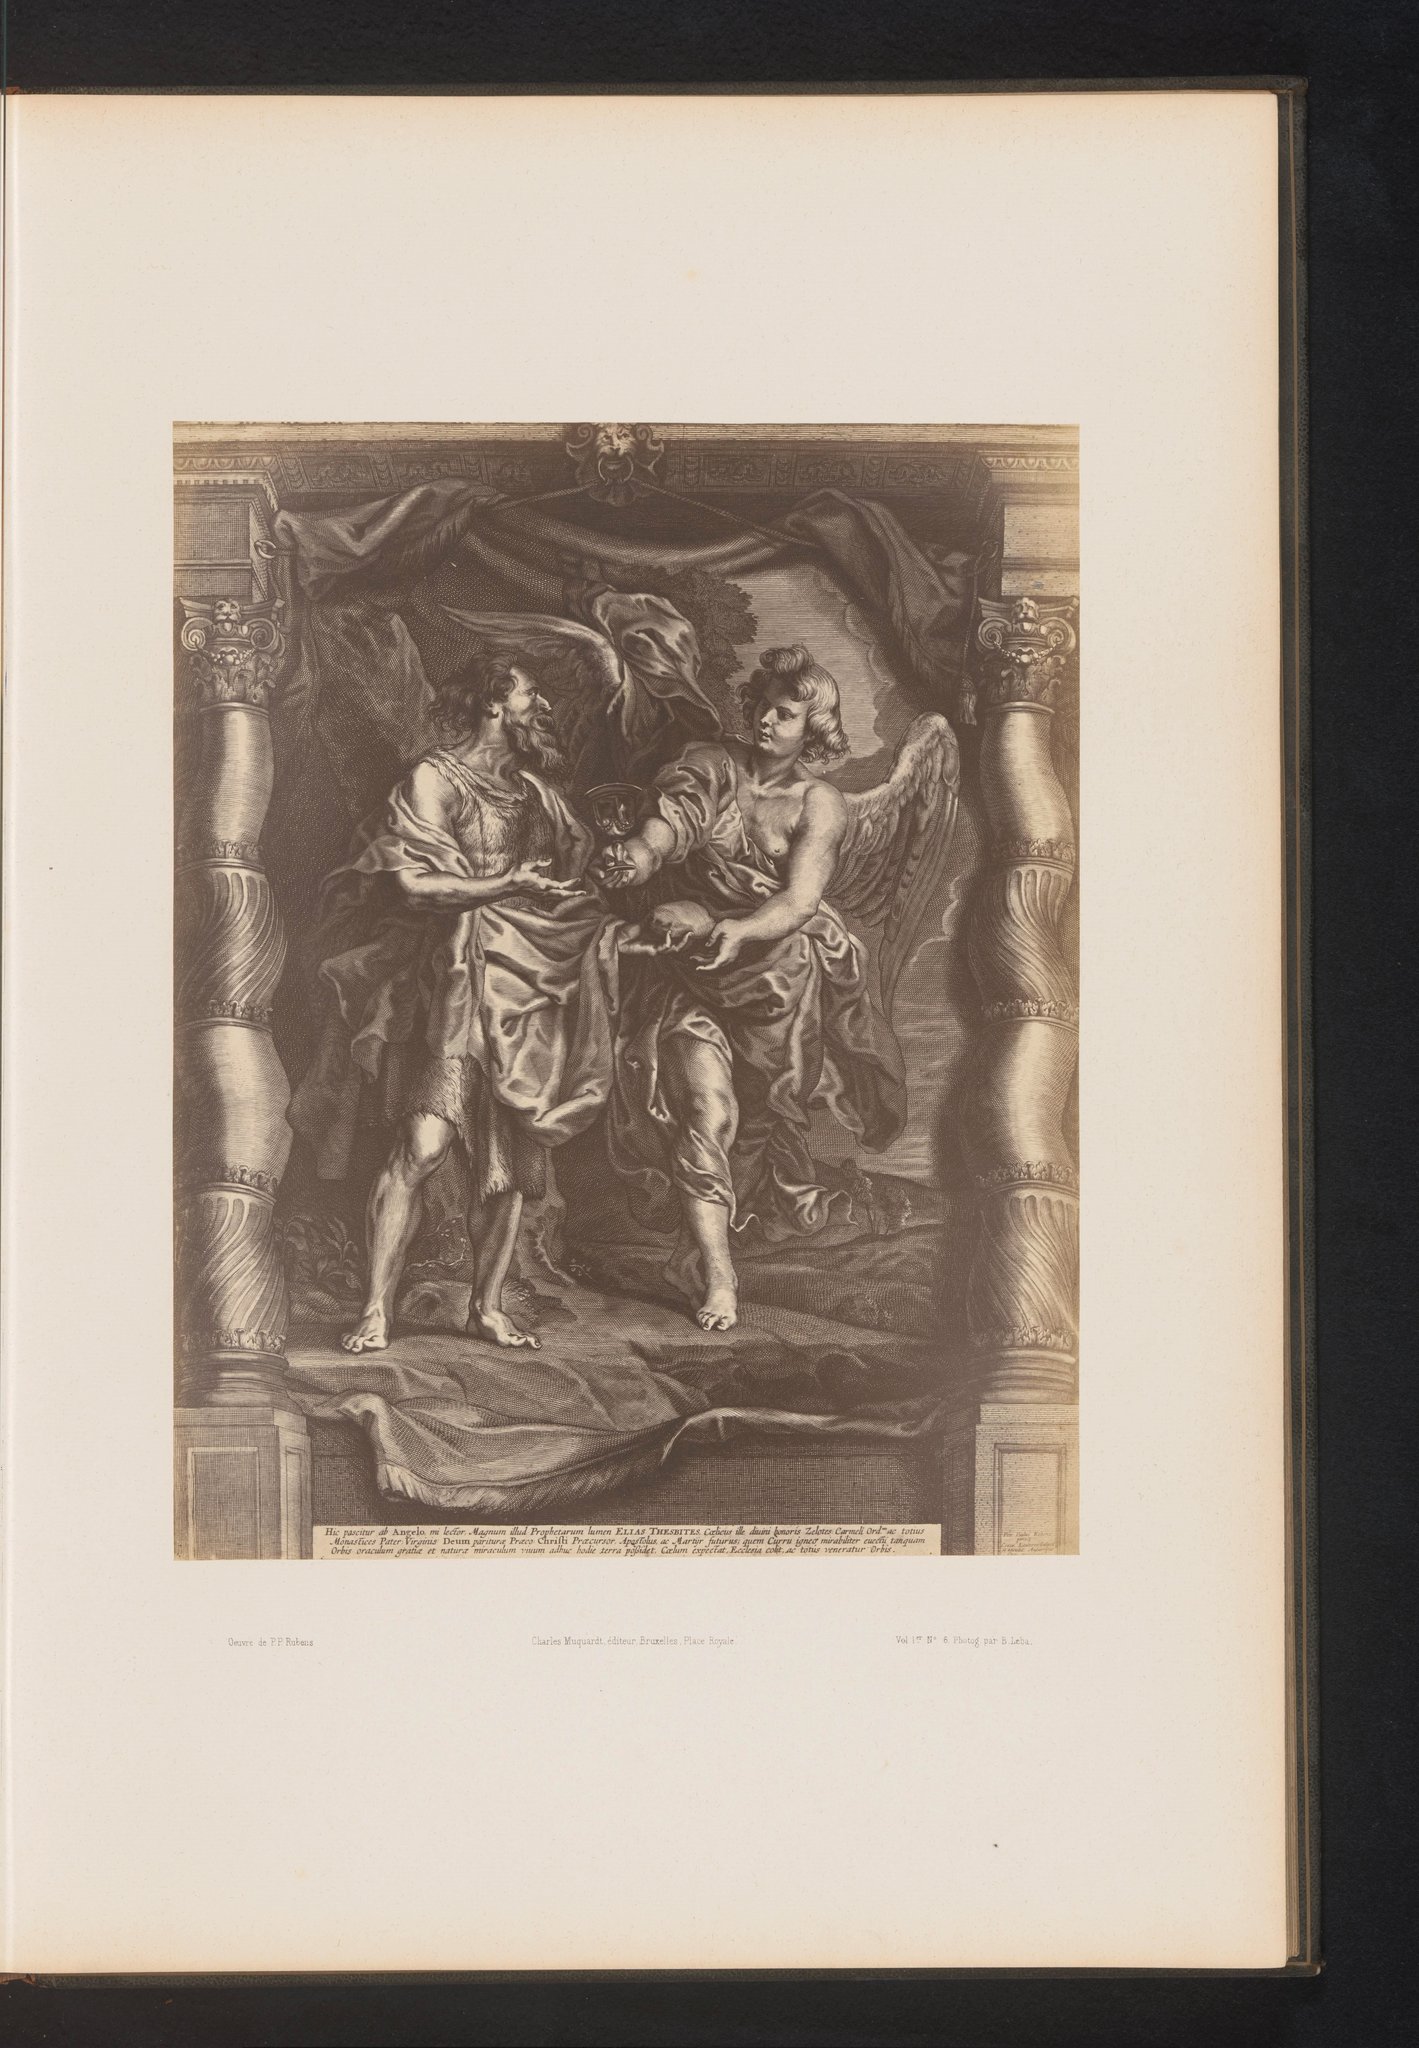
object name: photograph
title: Oeuvre de P.P. Rubens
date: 1853-1858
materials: photographic support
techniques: albumen print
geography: brussels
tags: elijah flees into the wilderness (desert)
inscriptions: number: ‘Vol. 1er. No 6.’